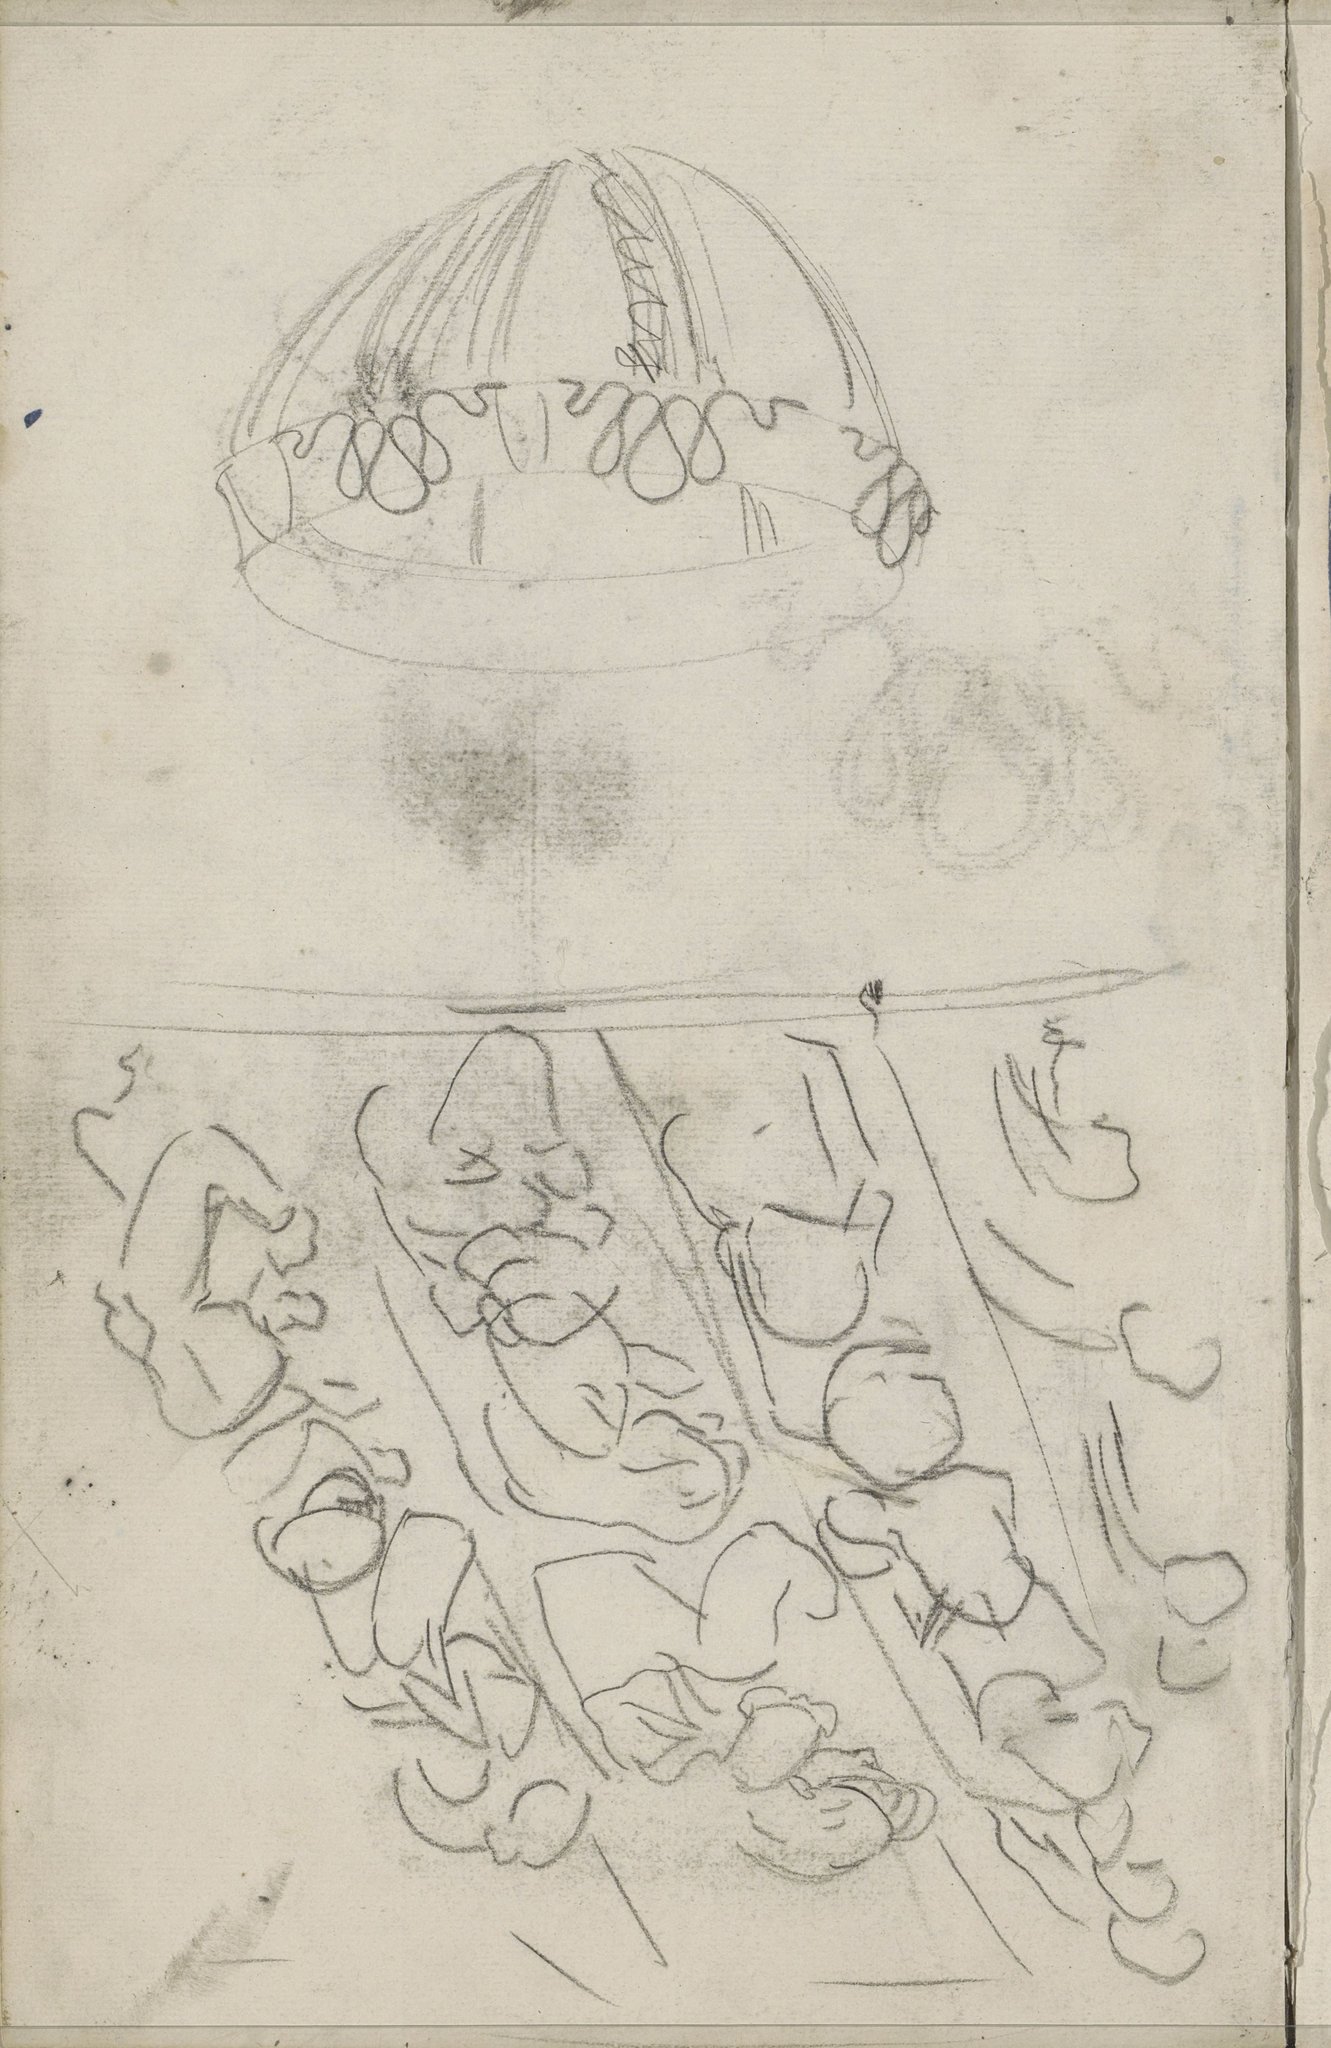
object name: sketchbook leaf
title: Kap van een hanglamp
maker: carel adolph lion cachet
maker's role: draughtsman, print maker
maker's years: 1864-1945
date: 1895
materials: chalk, paper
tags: child, lighting; lamps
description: Tevens een studie van kinderen gezeten aan lange tafels die in een rij achter elkaar zijn geplaatst. Blad 12 verso uit een schetsboek met 23 bladen.